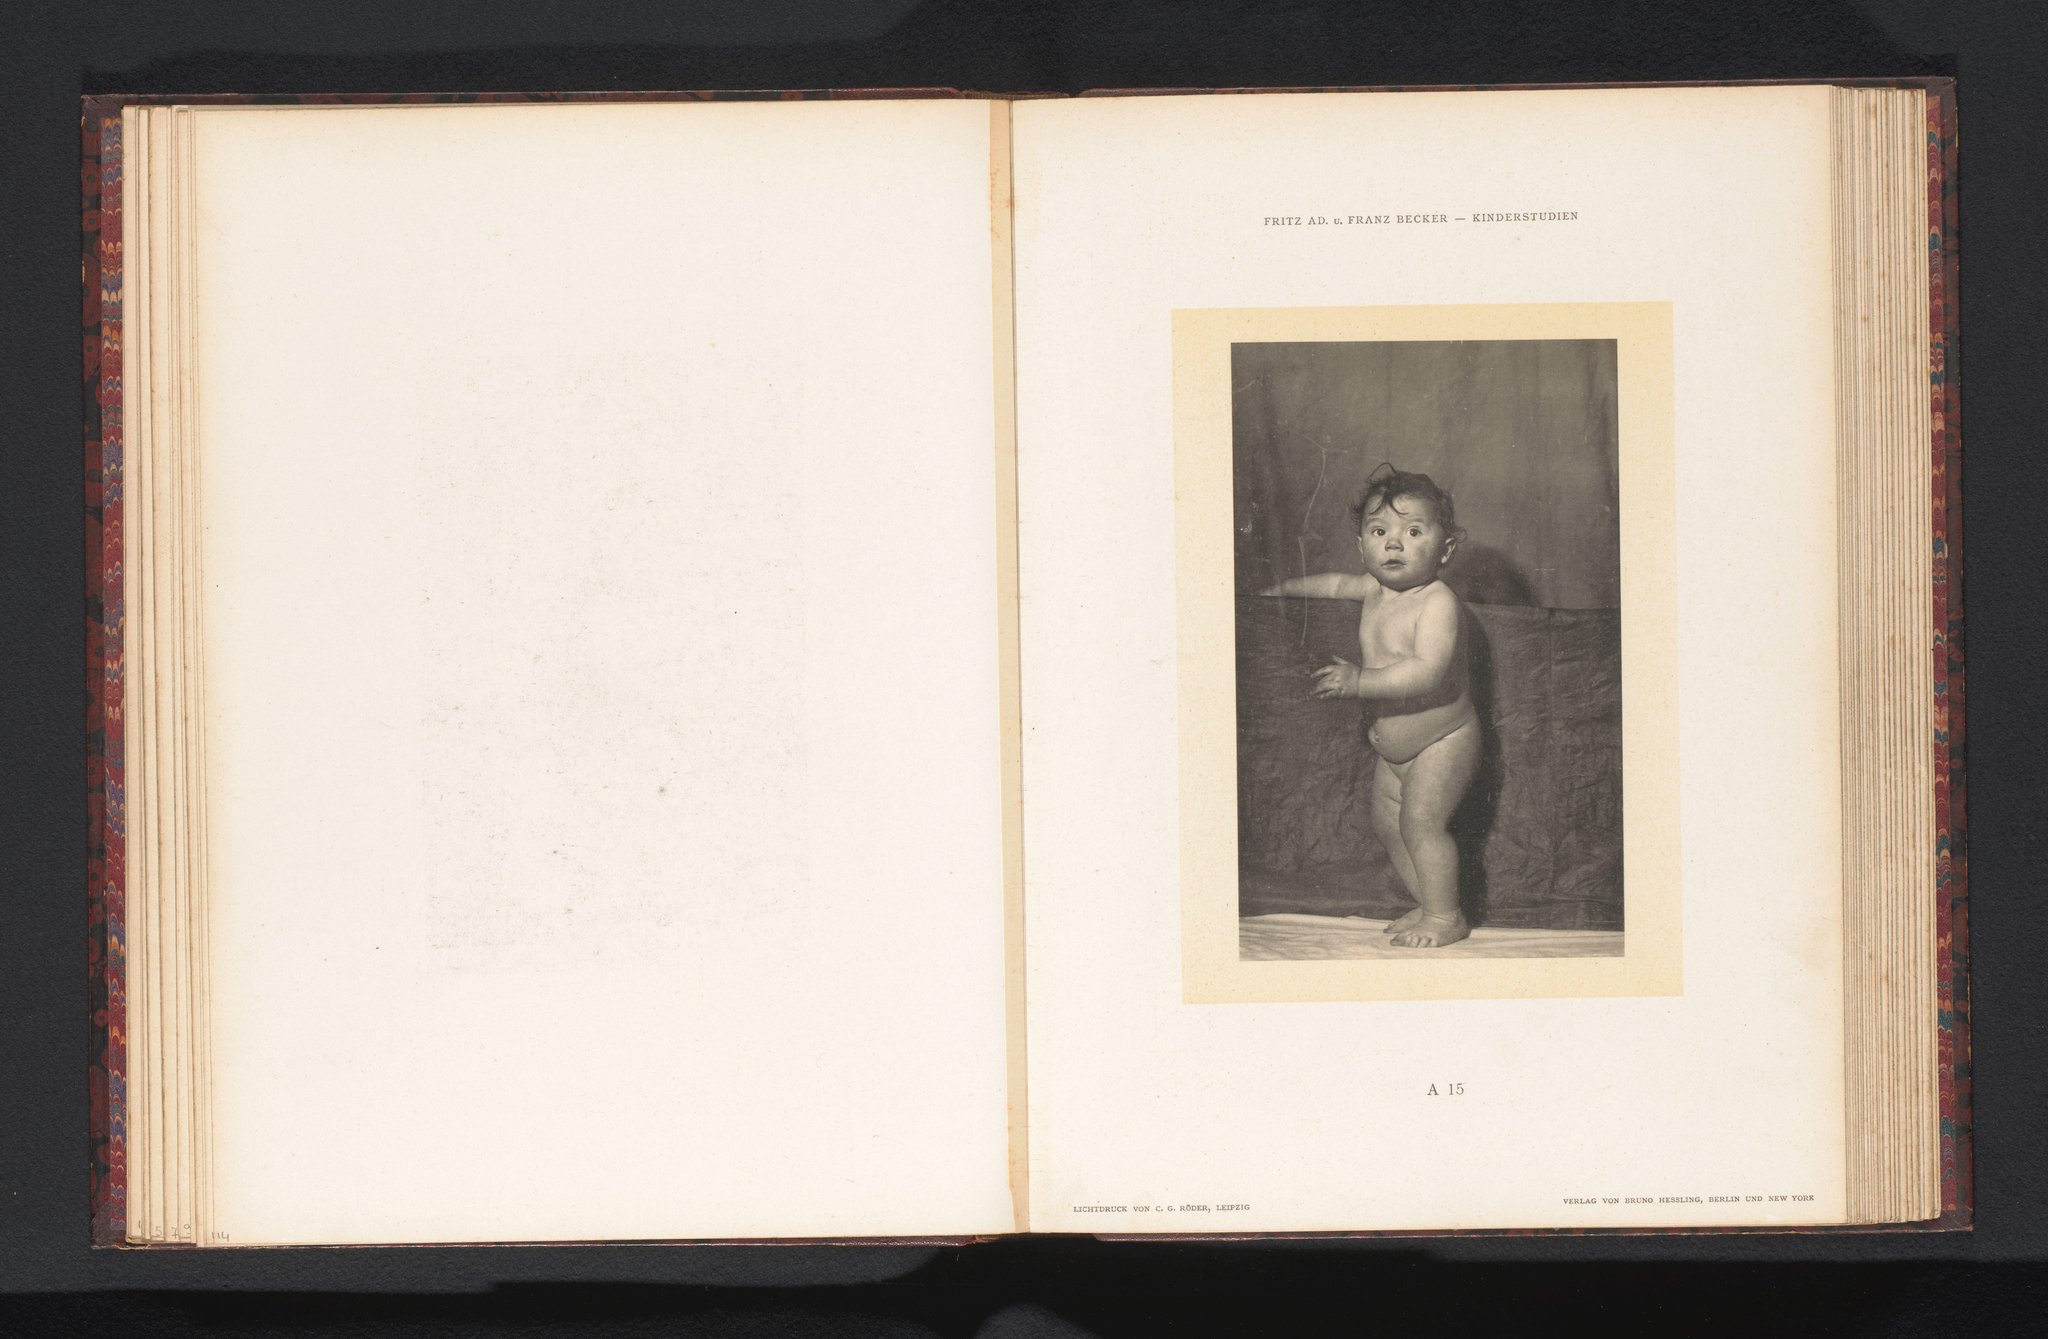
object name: page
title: Staande naakte jongen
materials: paper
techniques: photograph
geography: new york city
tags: standing figure, toddler (male)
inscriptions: number: ‘A 15’